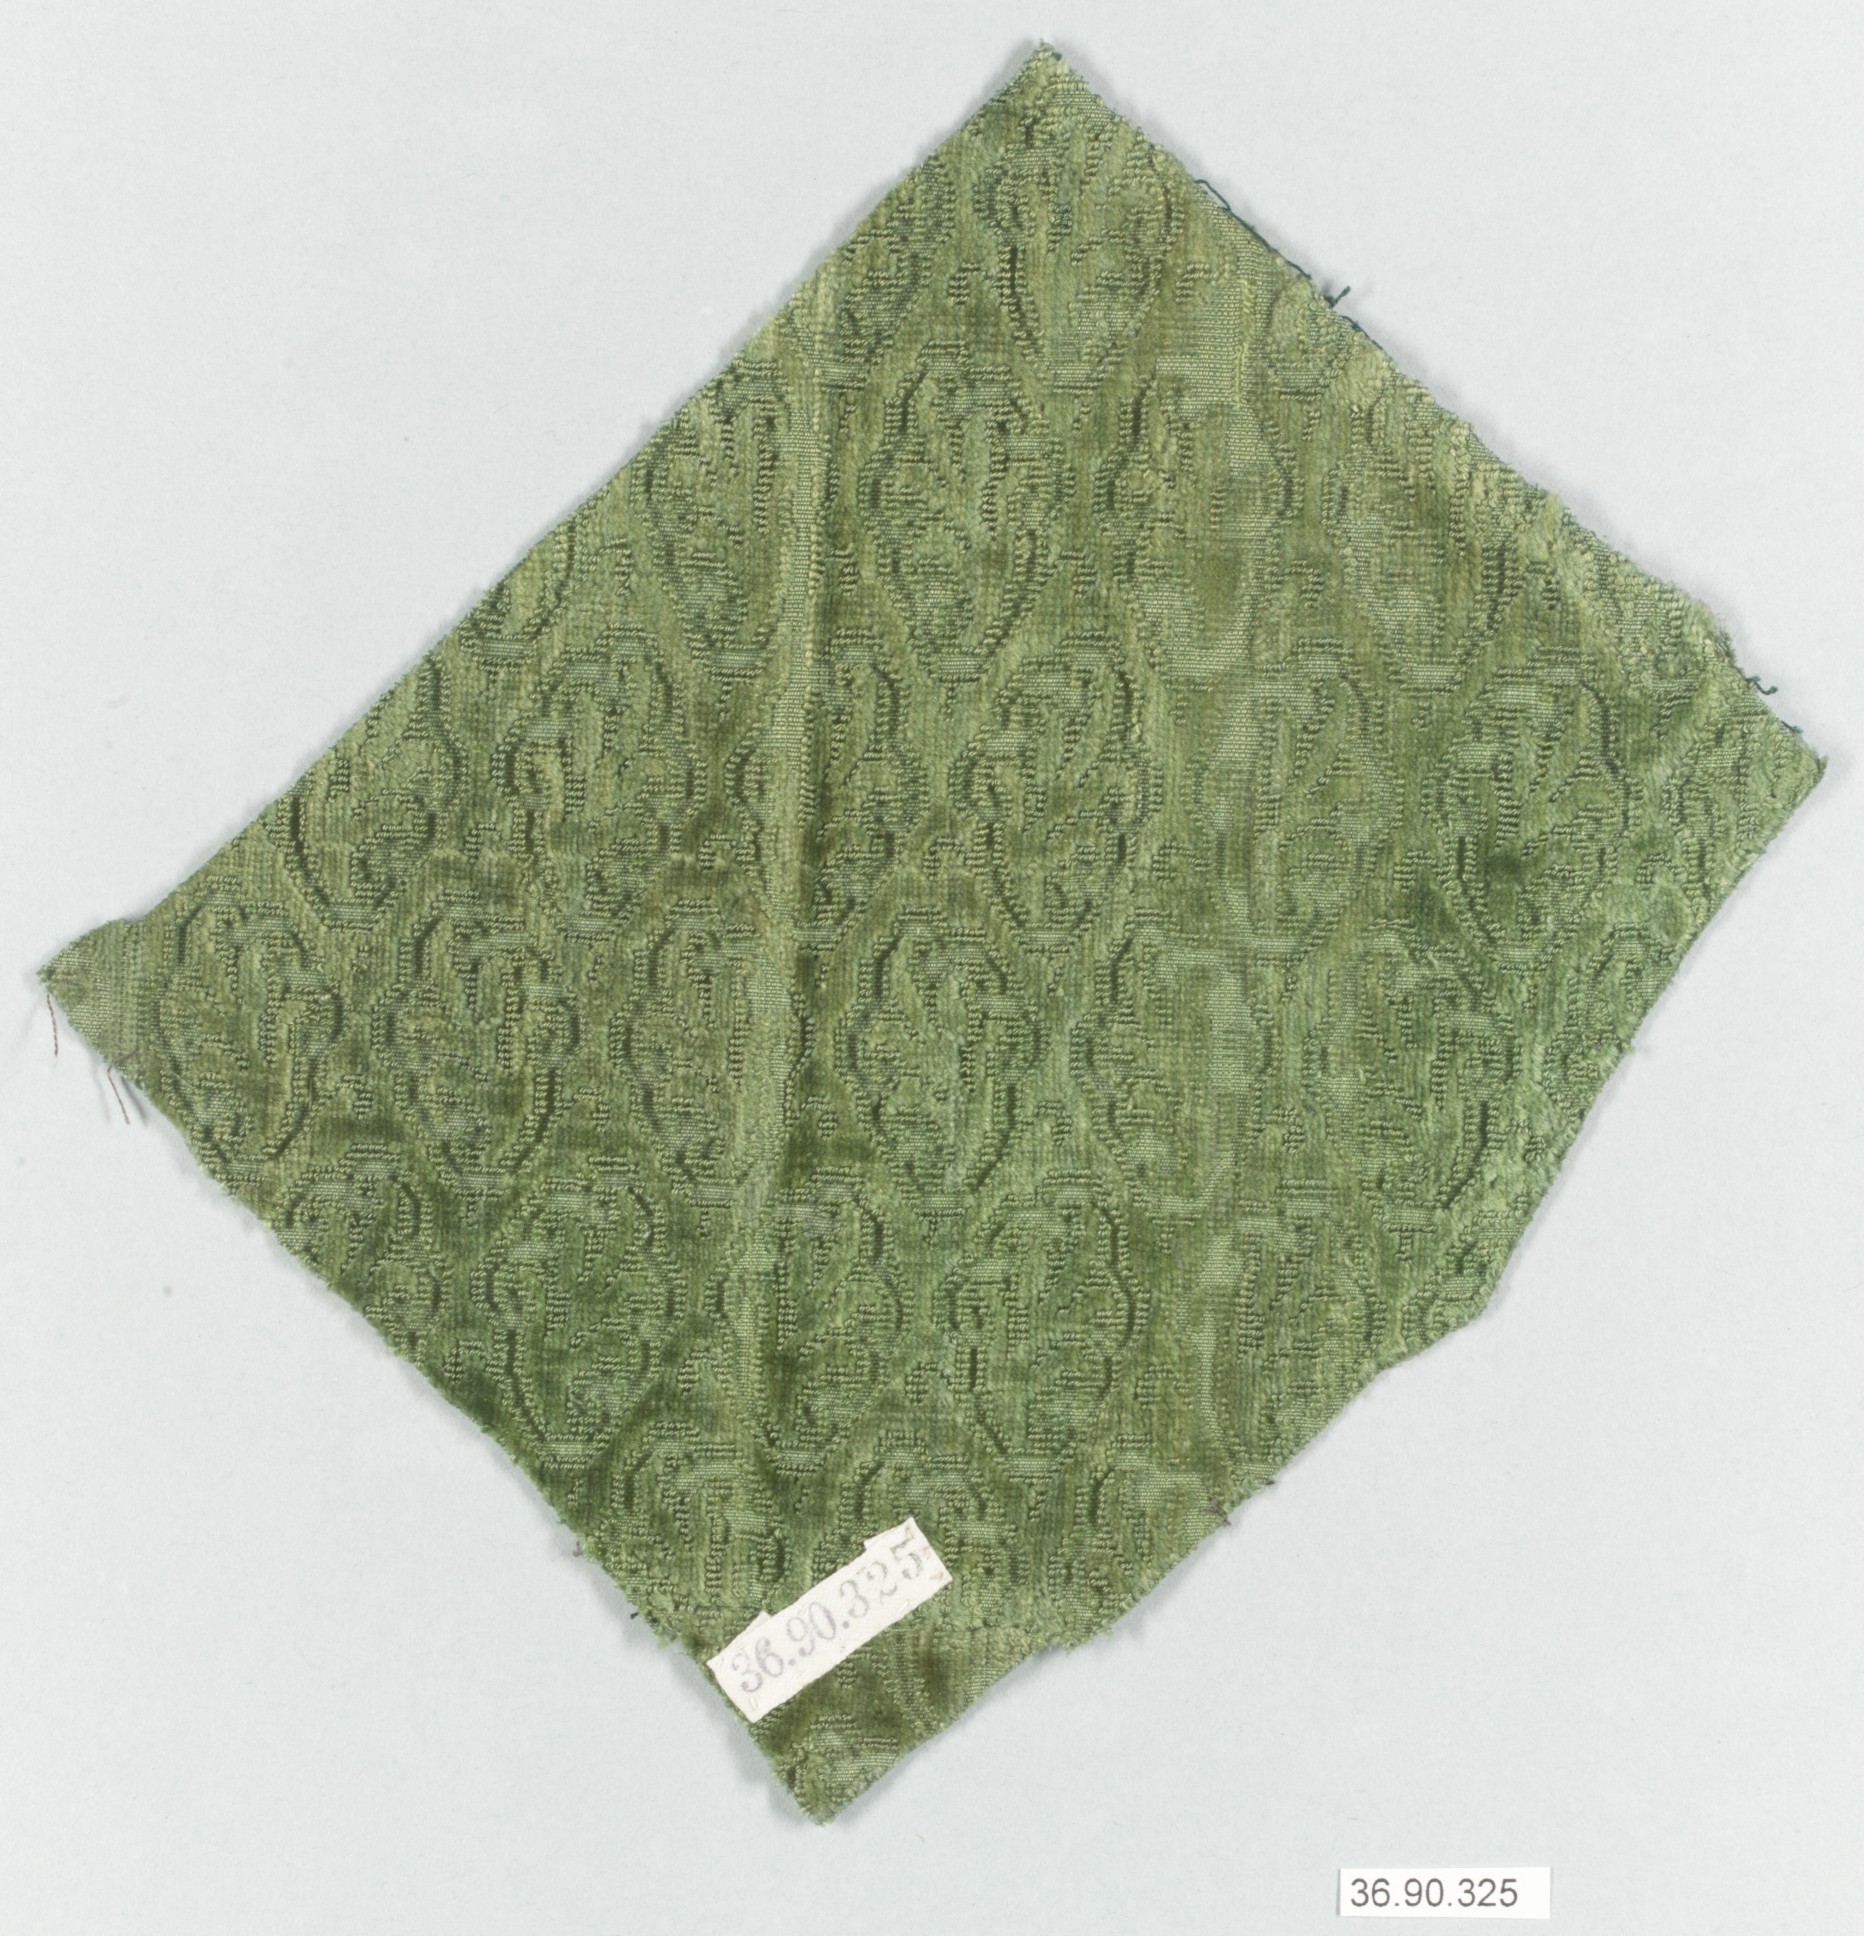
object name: piece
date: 1501-1700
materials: silk